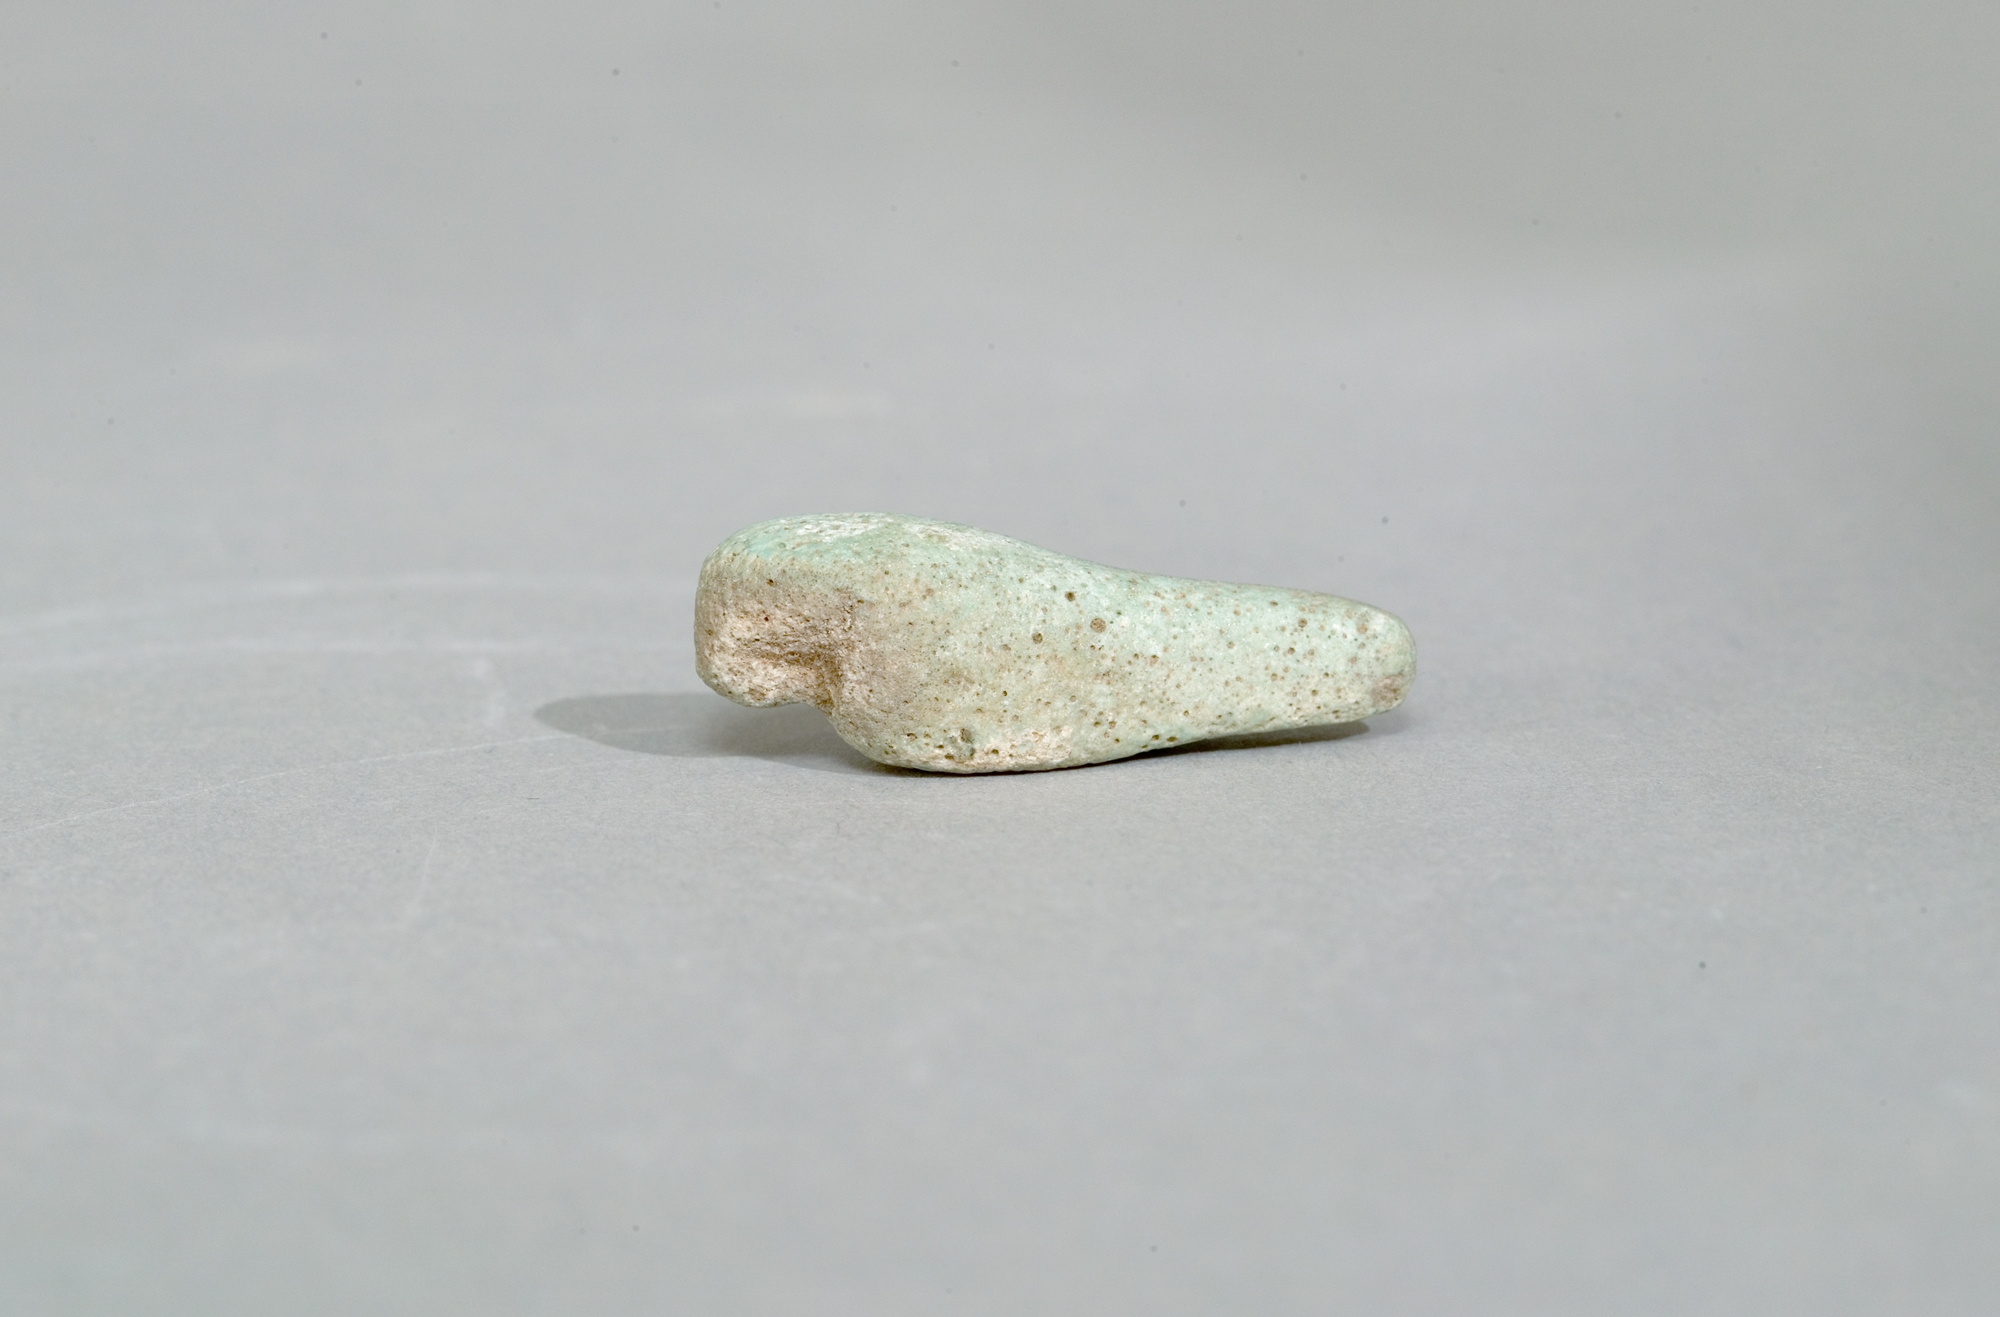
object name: figurine, falcon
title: Figurine of a crouching falcon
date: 3100-2650 BCE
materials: faience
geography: egypt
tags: falcons